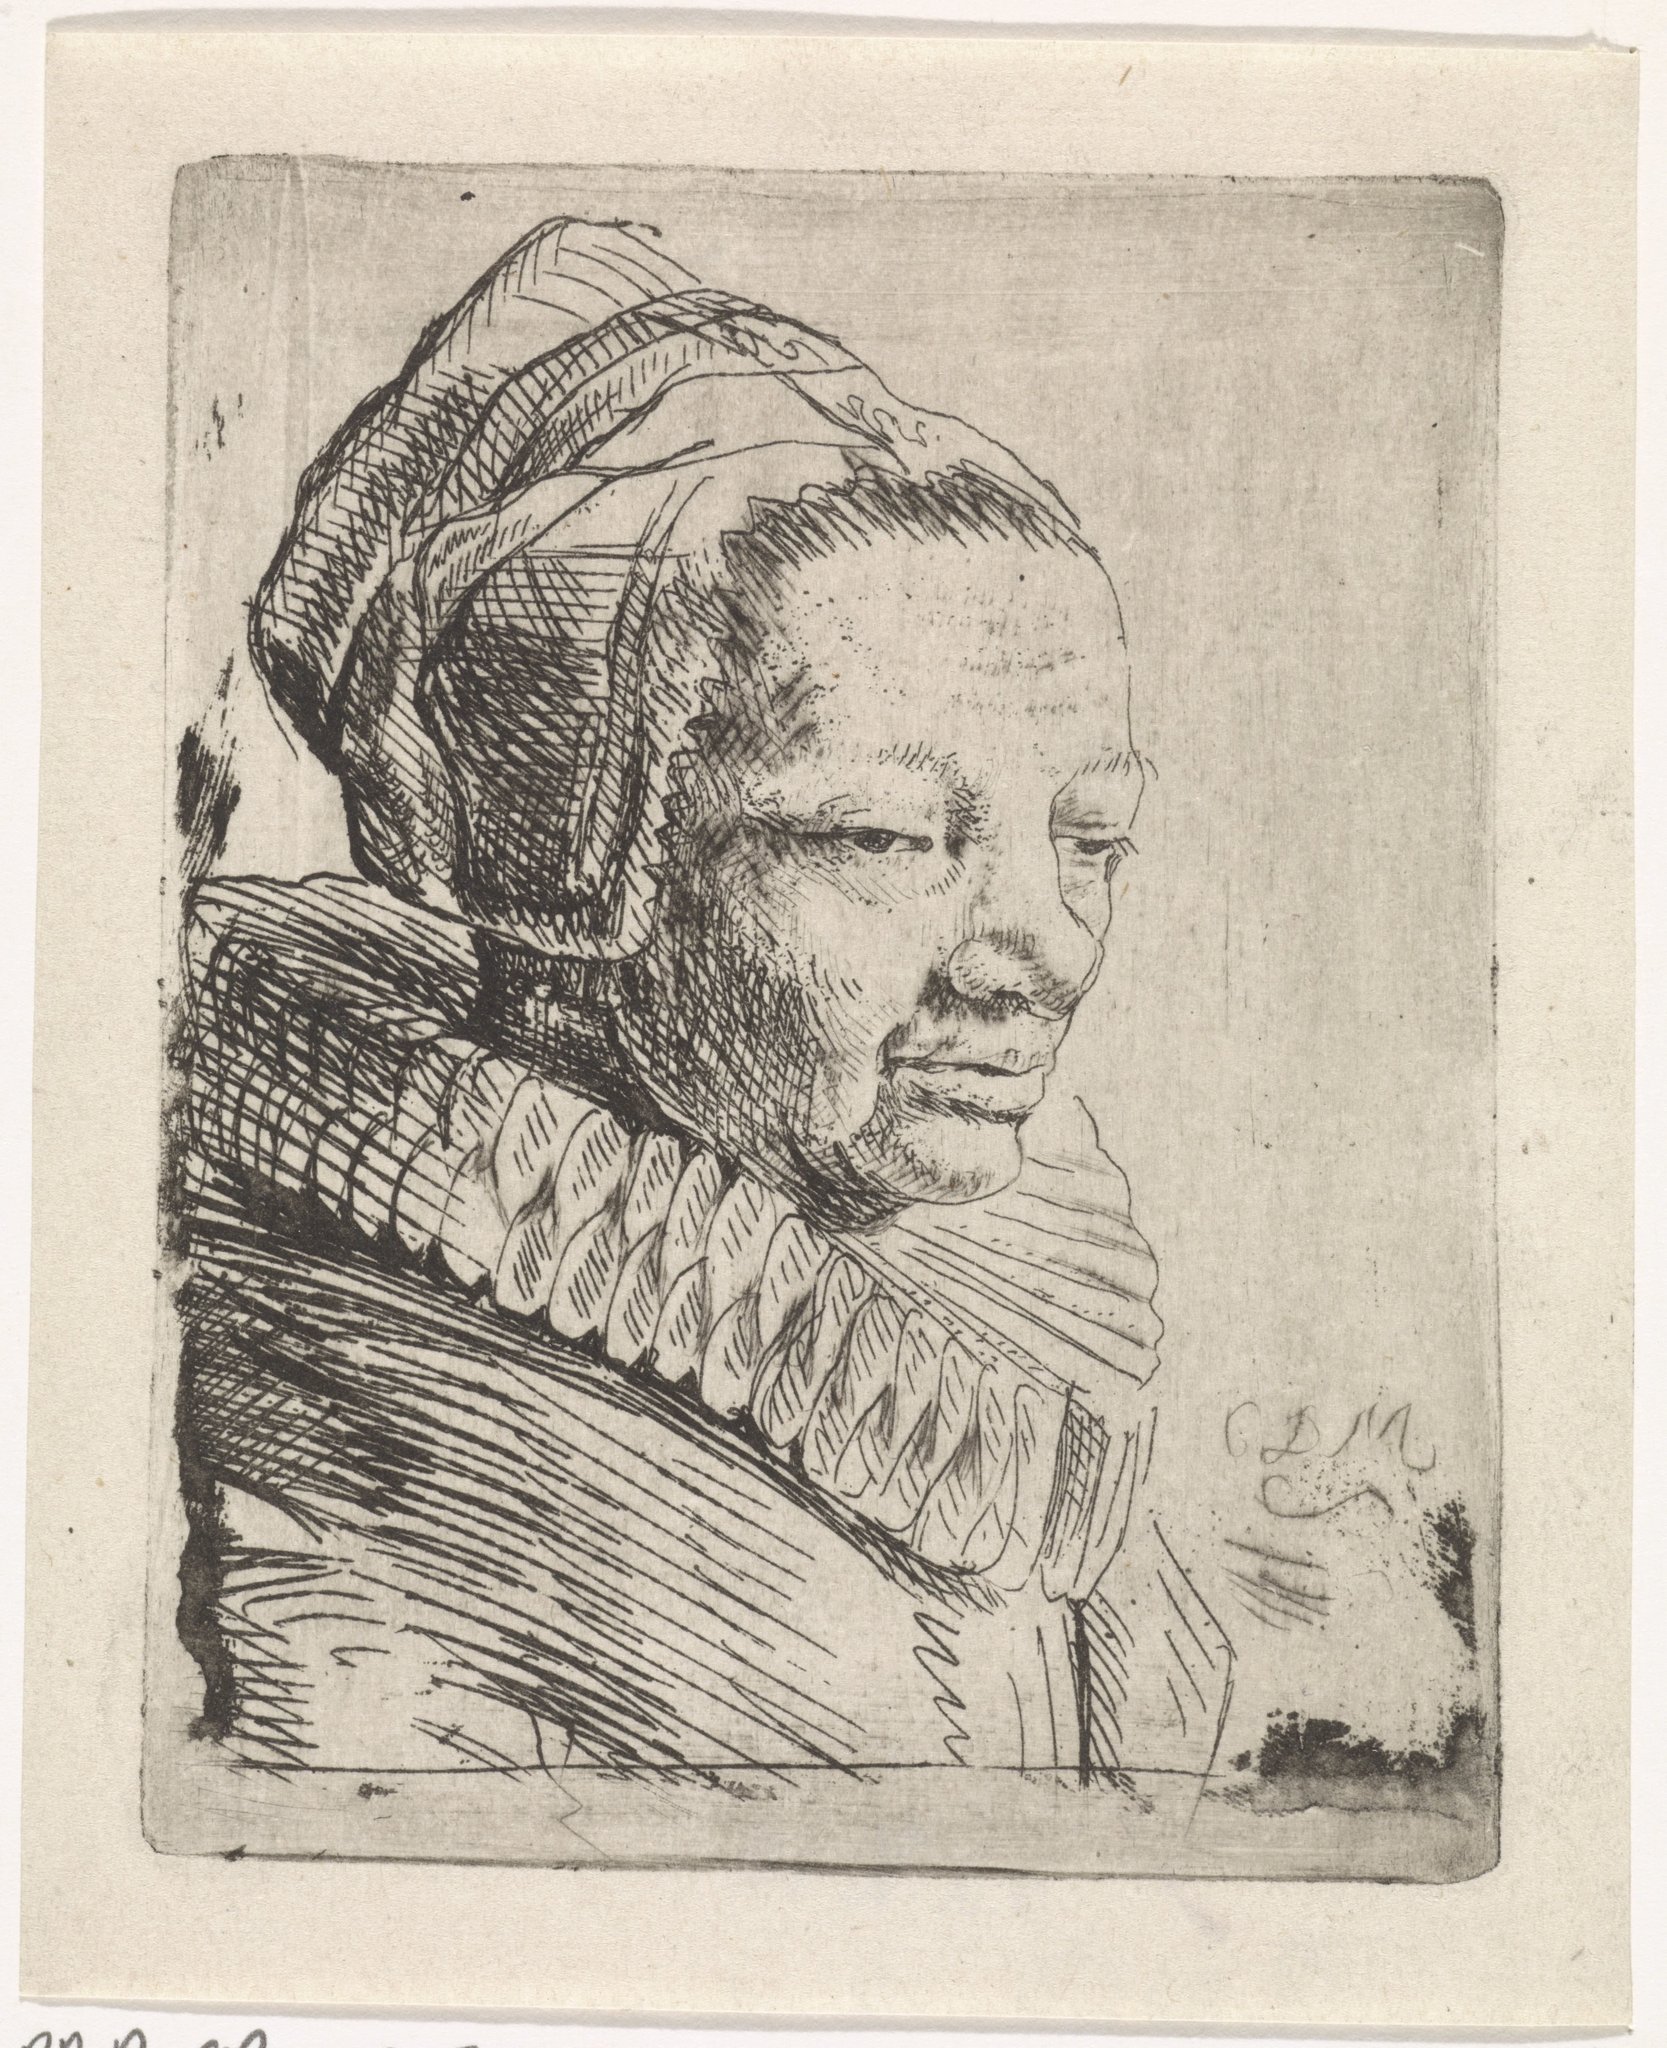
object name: print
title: Oude vrouw met een kapje op haar hoofd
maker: carel de moor (ii)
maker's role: draughtsman, painter, print maker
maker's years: 1655-1738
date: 1665-1738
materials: paper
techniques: etching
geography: netherlands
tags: head-gear, neck-gear ~ clothing (with name), neck-gear: collar (+ women's clothes), old woman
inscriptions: collector's mark: Lugt 240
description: Oude vrouw met een kapje op haar hoofd en plooikraag om haar nek.